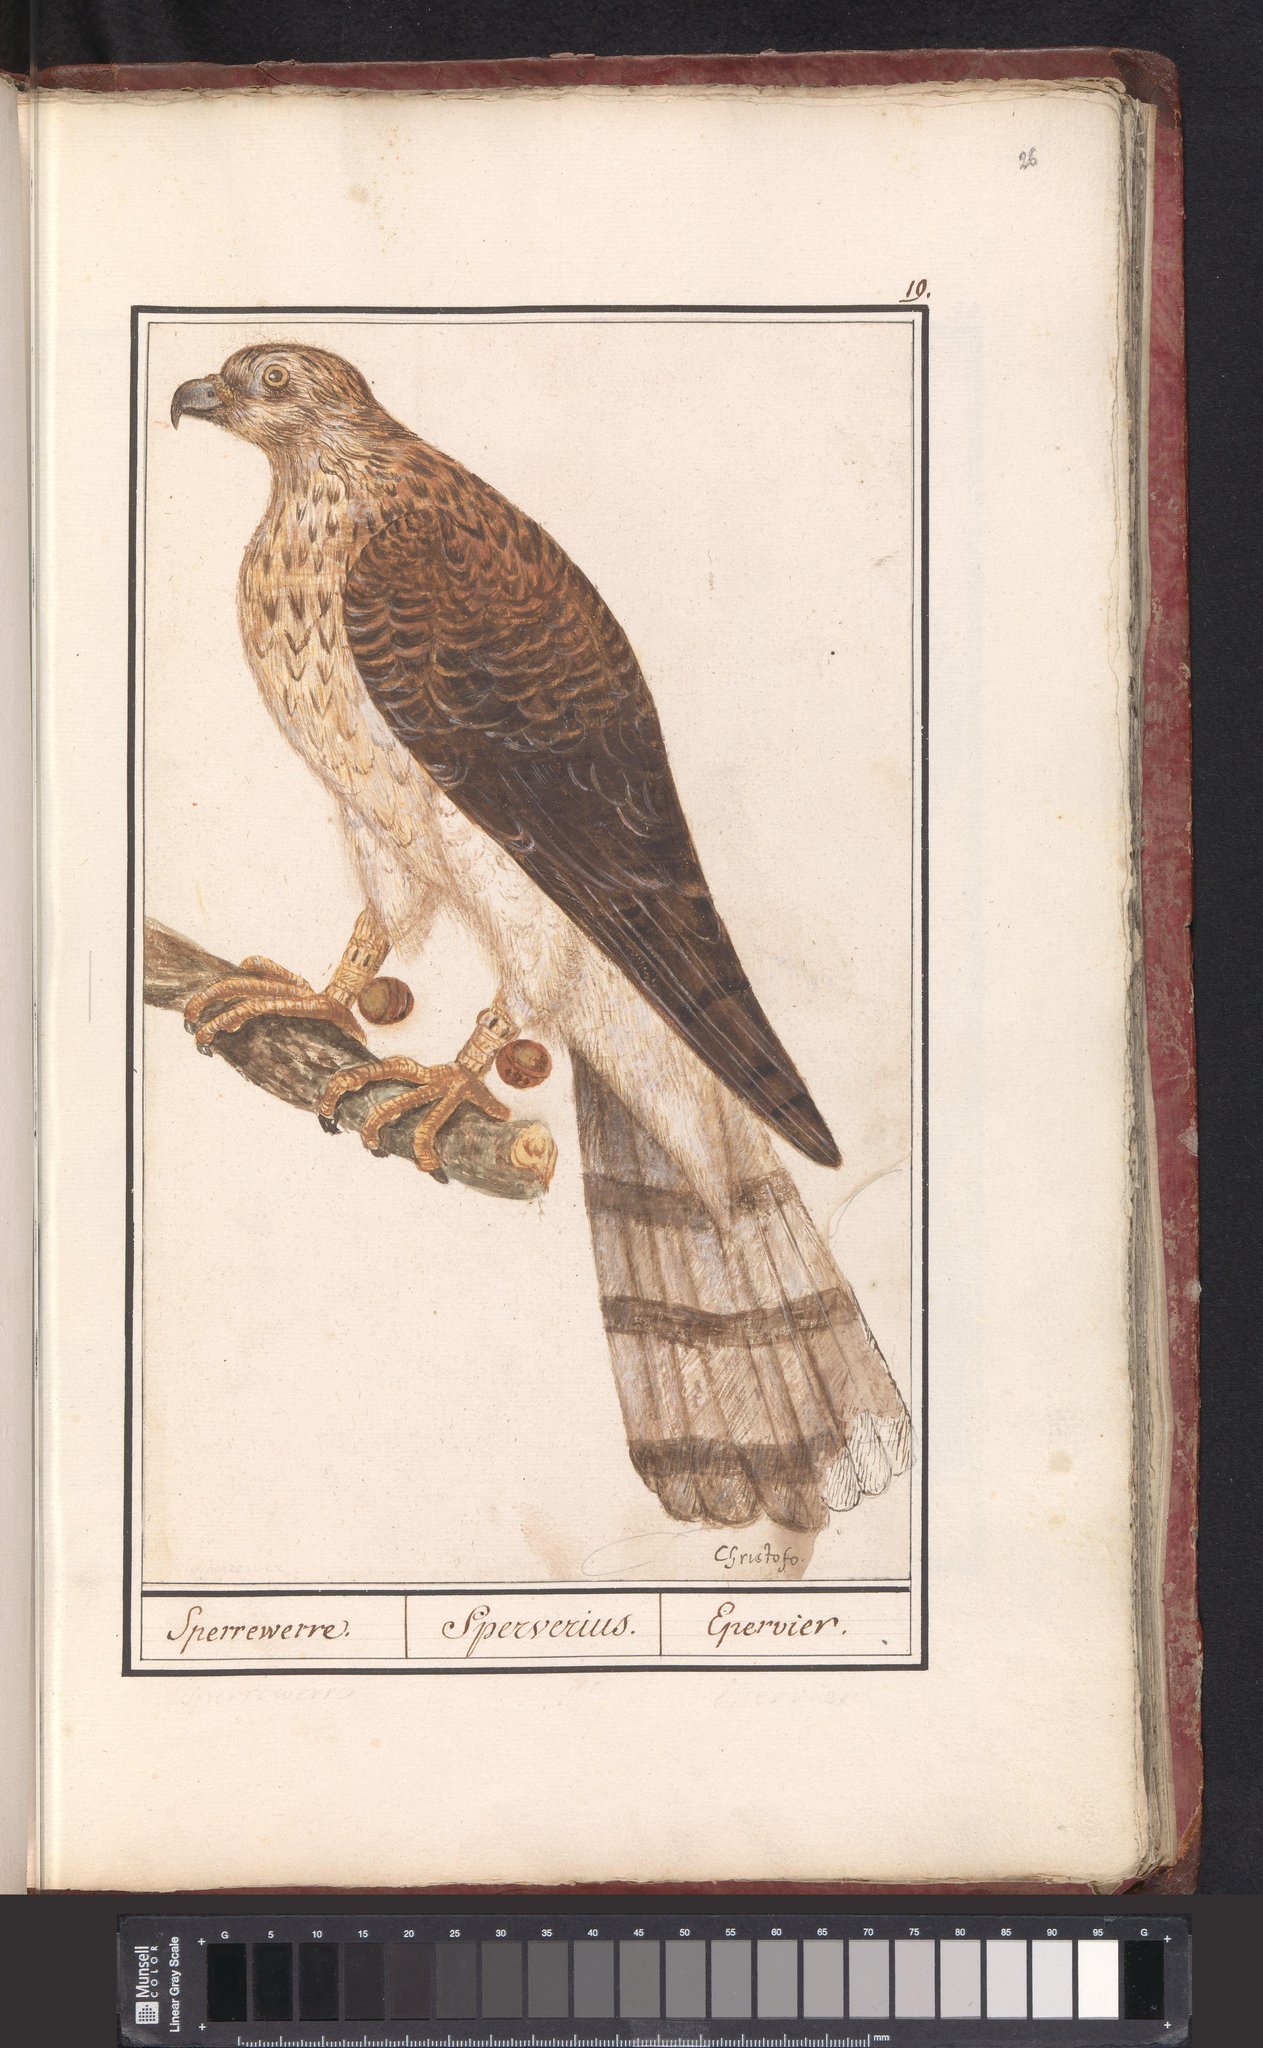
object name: drawing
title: Northern Goshawk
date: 1596-1610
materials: paint, paper, pencil, watercolor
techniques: brush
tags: predatory birds: northern goshawk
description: Havik, met belletjes bevestigd aan zijn poten. Genummerd rechtsboven: 19. Onderdeel van het eerste album met tekeningen van vogels. Derde van twaalf albums met tekeningen van dieren, vogels en planten bekend rond 1600, gemaakt in opdracht van keizer Rudolf II. Met toelichting in Nederlands, Latijn en Frans.